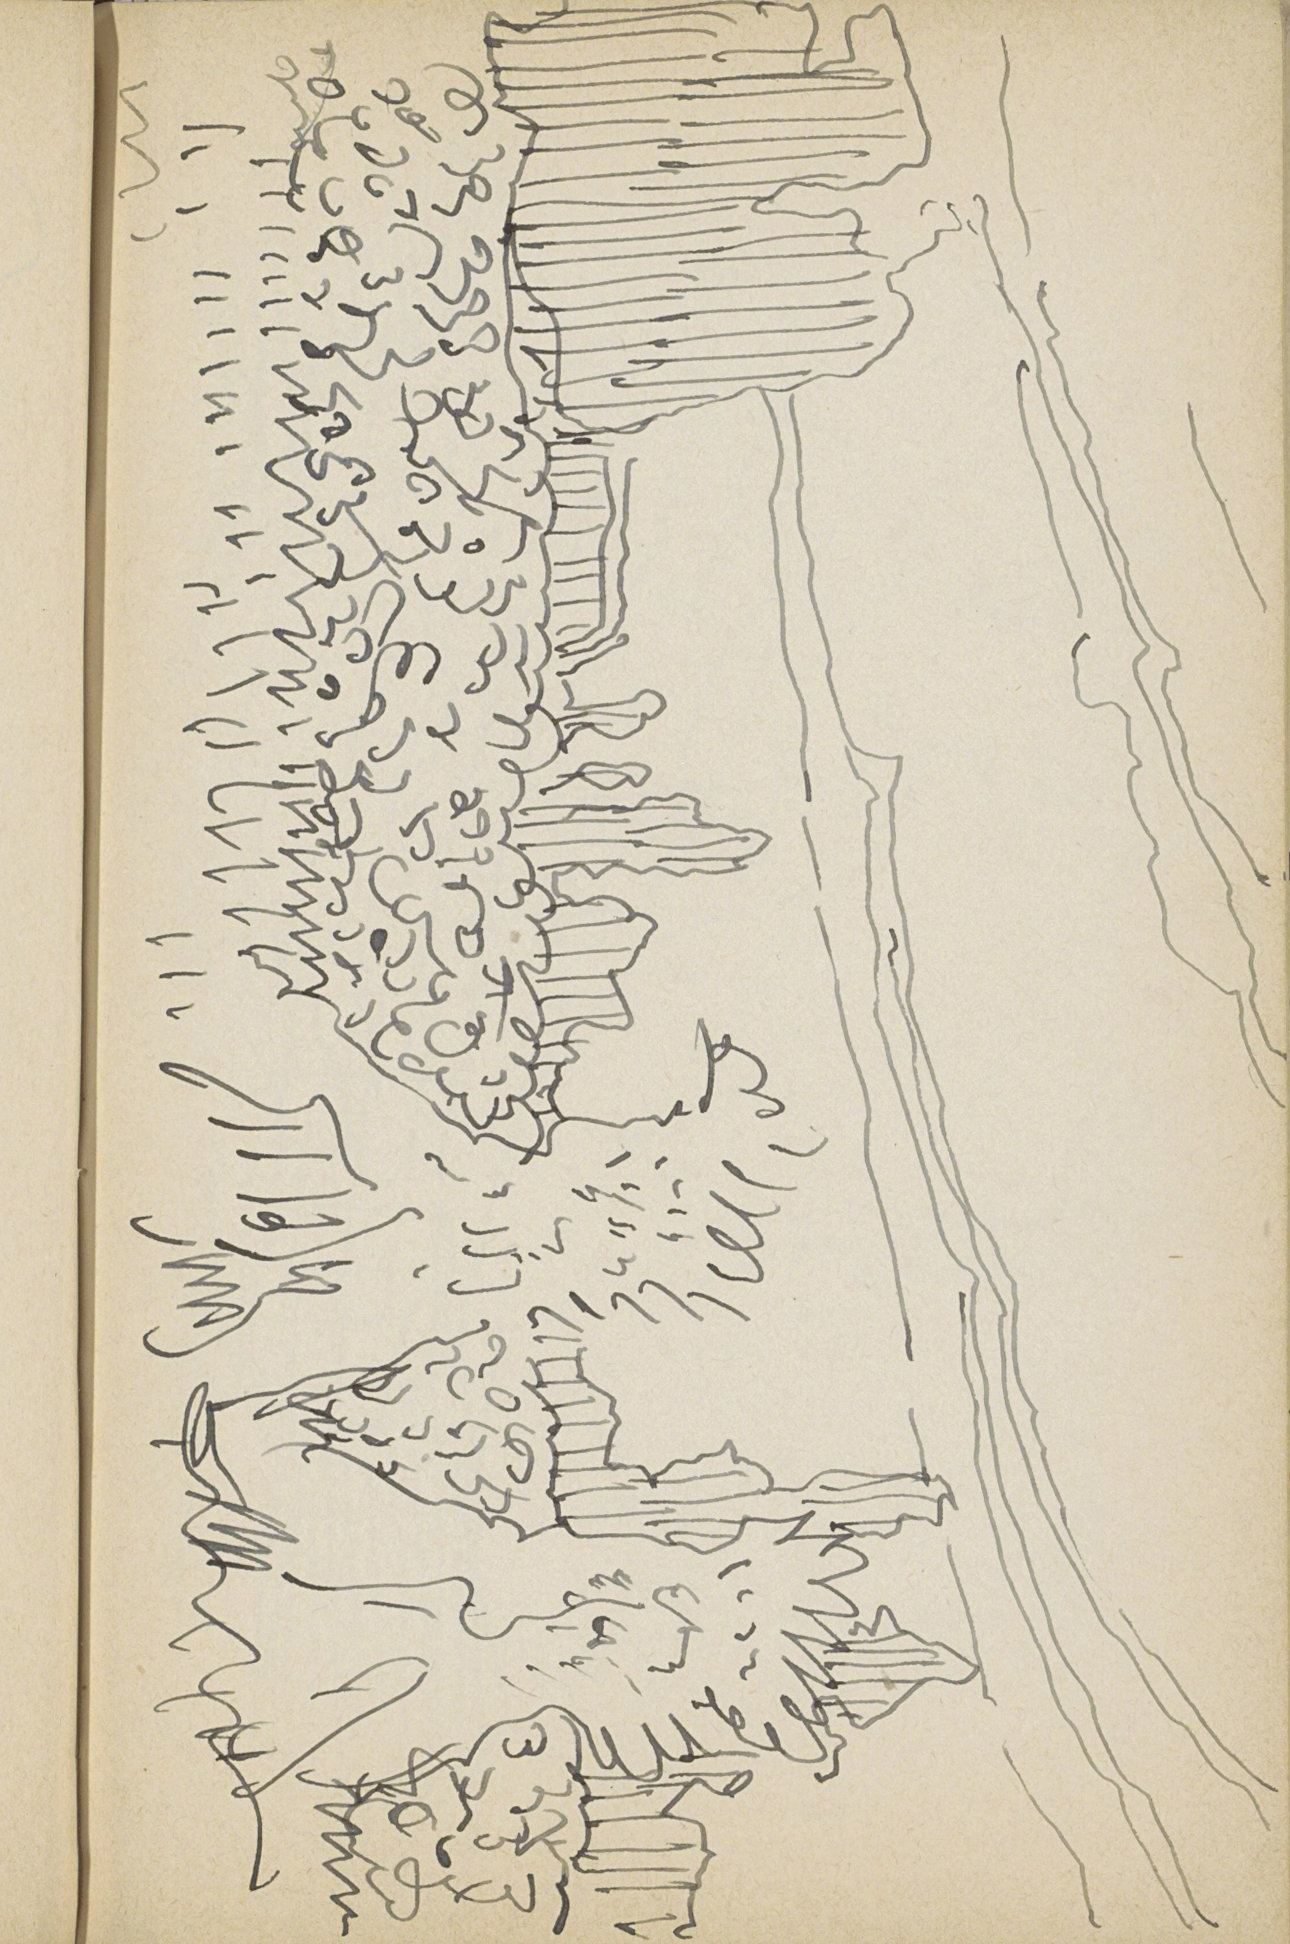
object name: sketchbook leaf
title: Landschap met bomen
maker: reijer stolk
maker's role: draughtsman, print maker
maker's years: 1896-1945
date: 1908-1919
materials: ink, paper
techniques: pen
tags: landscapes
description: Blad 22 recto uit een schetsboek met 33 bladen.